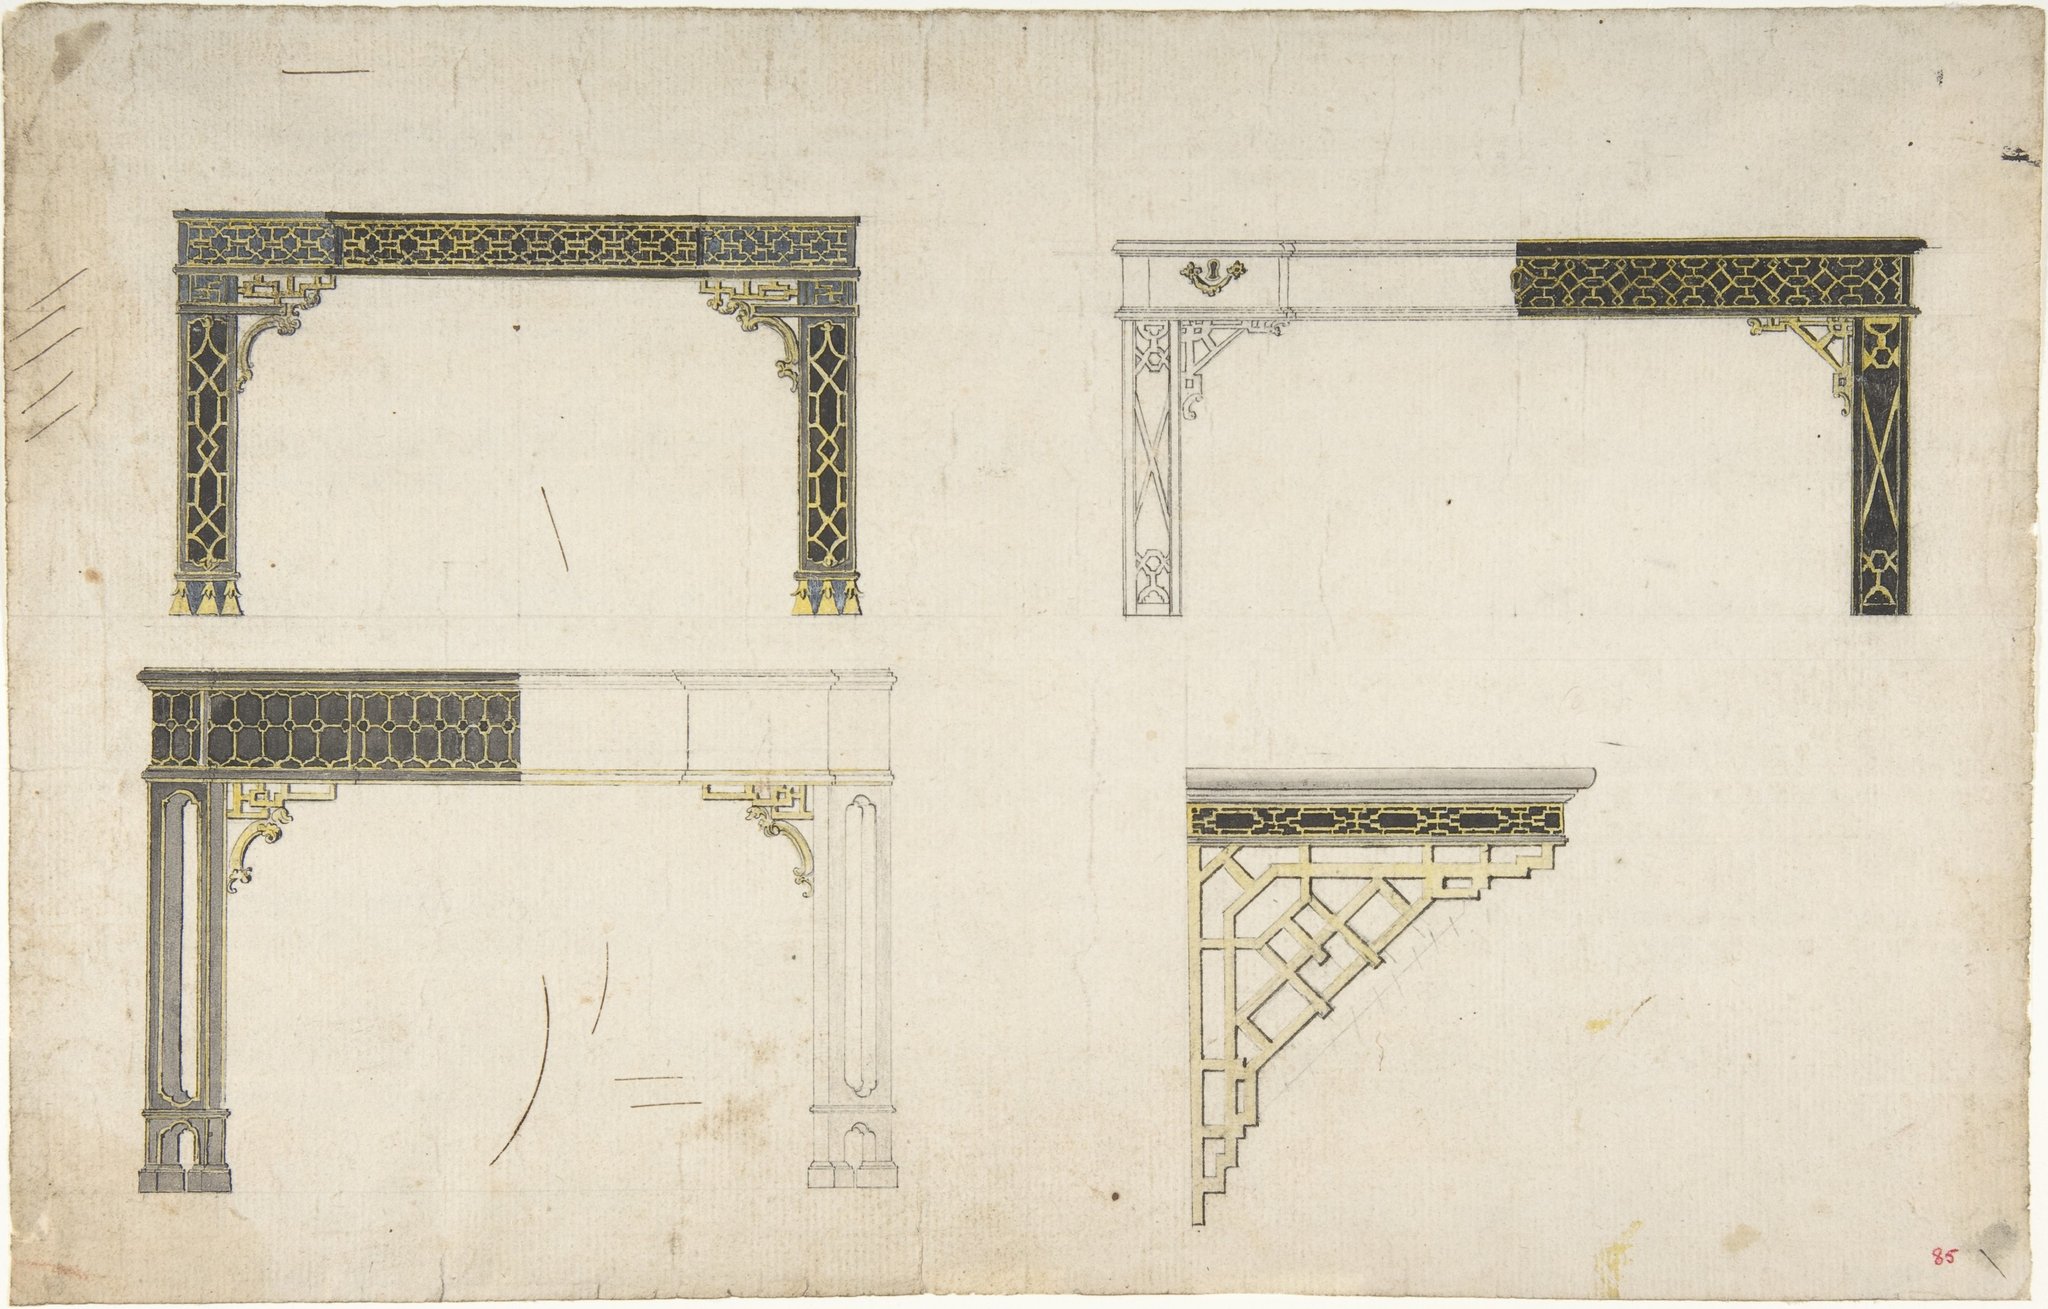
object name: drawing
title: Designs for Tables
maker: anonymous, french, 18th century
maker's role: artist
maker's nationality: french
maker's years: 1700-1800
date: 1770-1790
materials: chalk, ink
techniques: brush, pen, wash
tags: tables